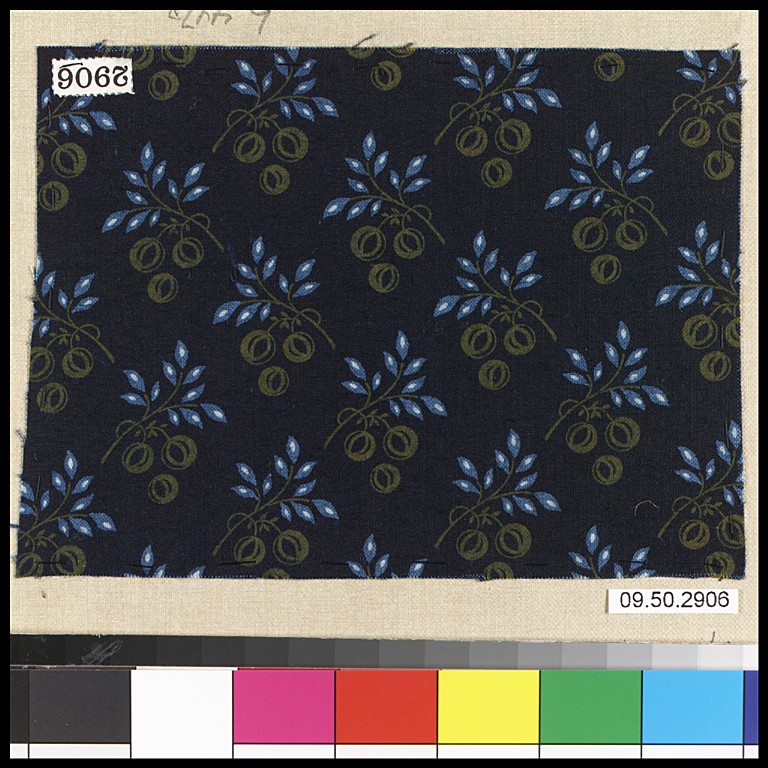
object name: piece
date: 1801-1900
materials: cotton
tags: fruit,leaves